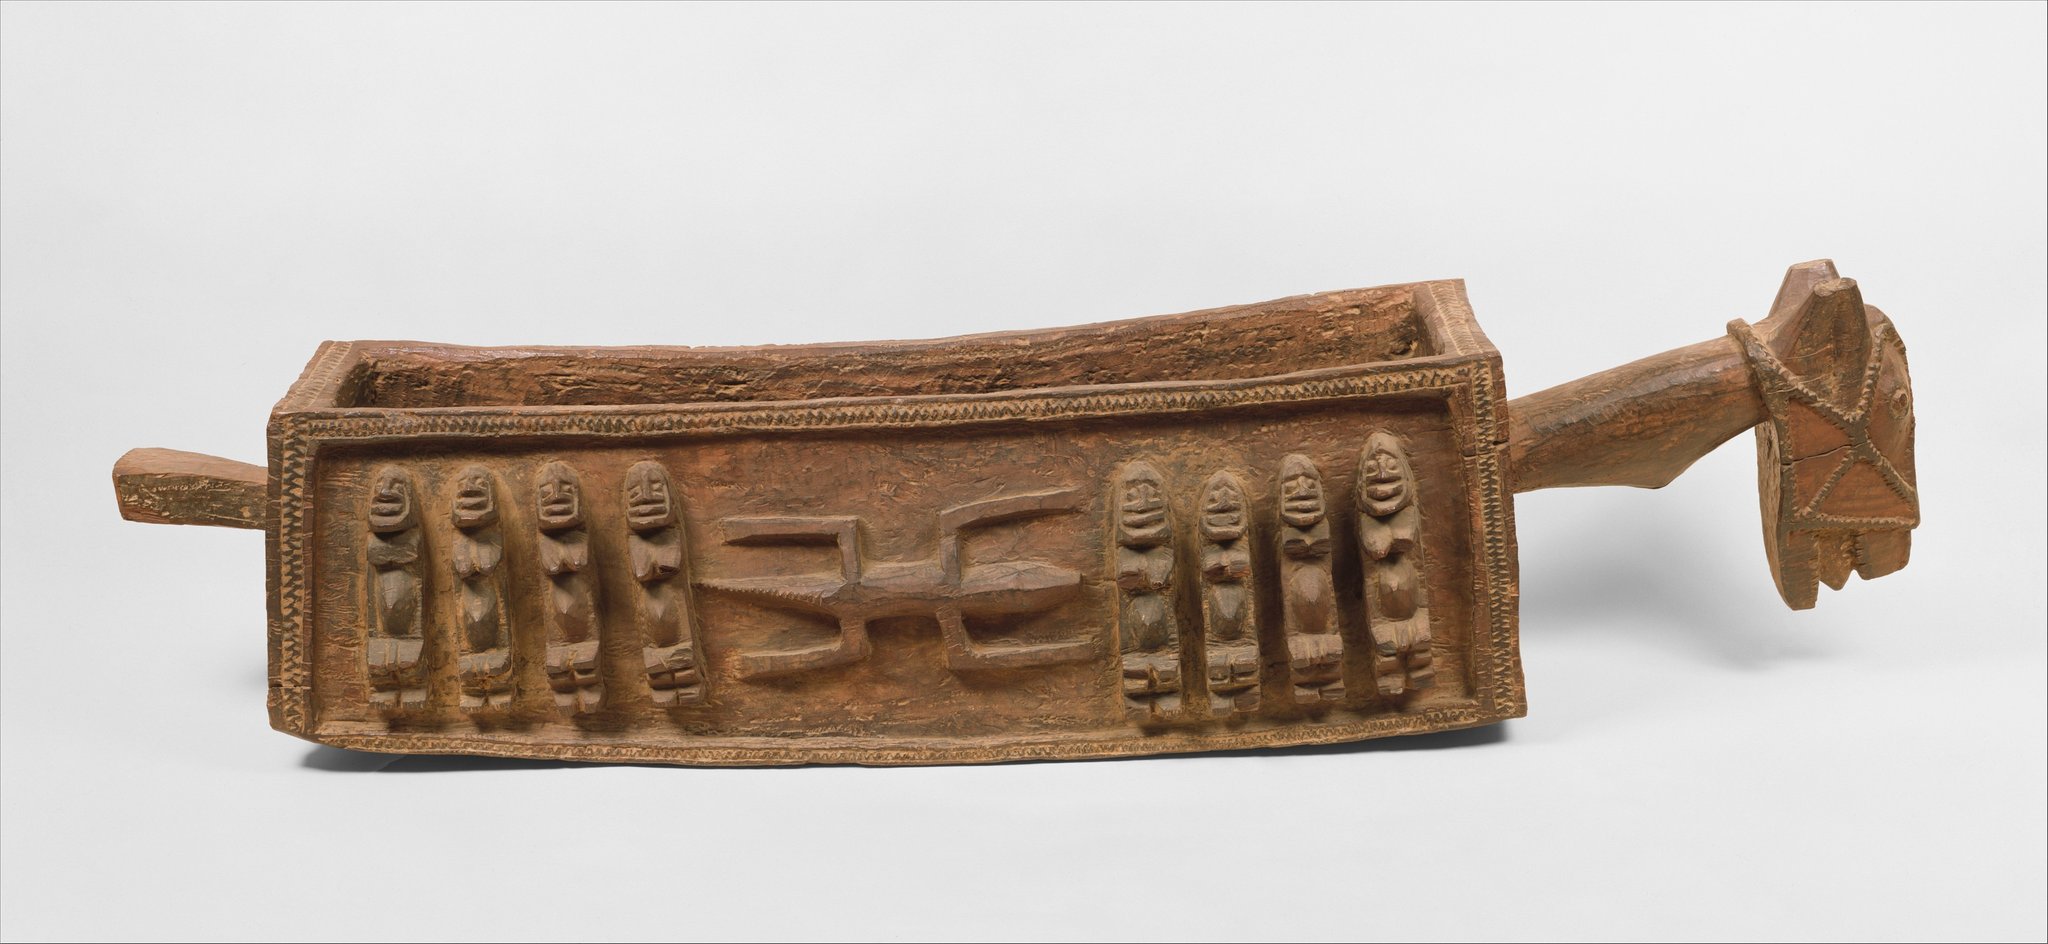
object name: ritual vessel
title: Aduno Koro (Ark of the World) vessel with ancestral figures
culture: dogon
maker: dogon blacksmith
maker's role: artist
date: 1501-1900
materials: wood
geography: mali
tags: human figures,horses,ritual objects